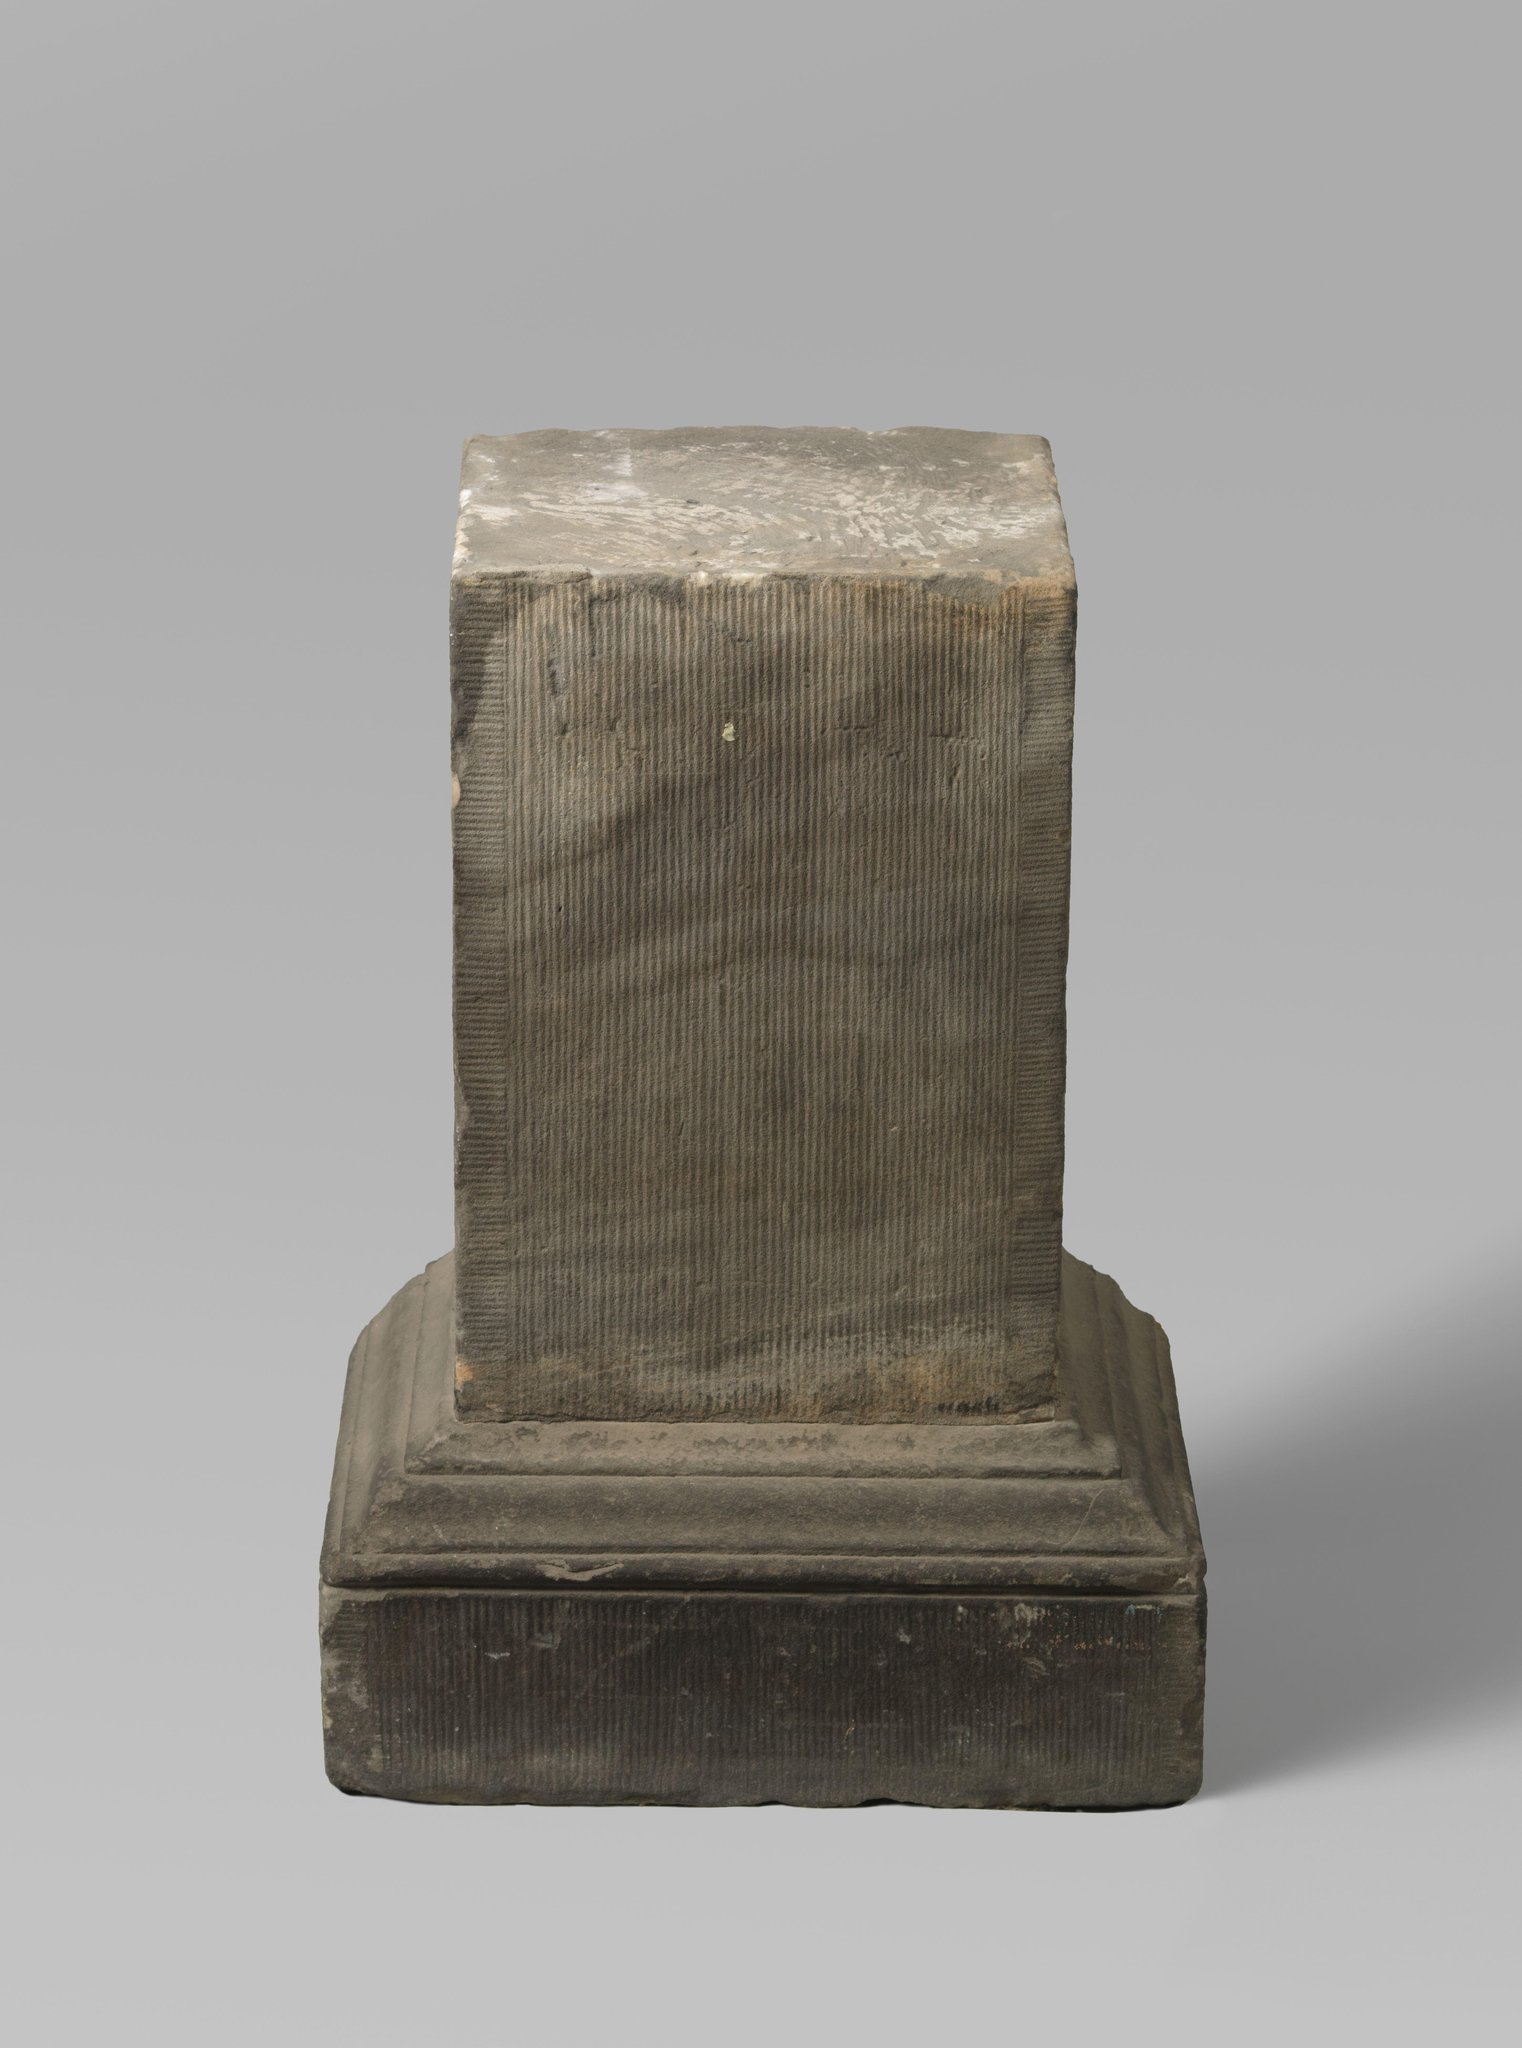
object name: pedestal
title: Rechthoekige sokkel van zandsteen, behorend bij Beeld, de fortuin verbeeldend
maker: Anonymous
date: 1800-1899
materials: cement, stone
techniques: carved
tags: the hague, constantijn huygens (i)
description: Rechthoekige sokkel van zandsteen, behorend bij 'Beeld, de fortuin verbeeldend'. Het bovenblad van de sokkel zit aan het beeldhouwwerk BK-18042-B-1 vast. De bovenzijde van de sokkel is flink beschadigd en verkleurd, doordat het bovenblad van de sokkel is verwijderd. Ter hoogte van rand van de bovenzijde ontbreken veel schilfers van het zandsteen. De zijkanten van de sokkel zijn vlak. De plint is met cement aan de schacht bevestigd en is overkragend, doordat een geprofileerde rand de sokkel verbreed. De schacht van de sokkel steekt ter hoogte van de achterzijde 4 centimeter uit. De sokkel is een pendant van BK-18042-A-2.